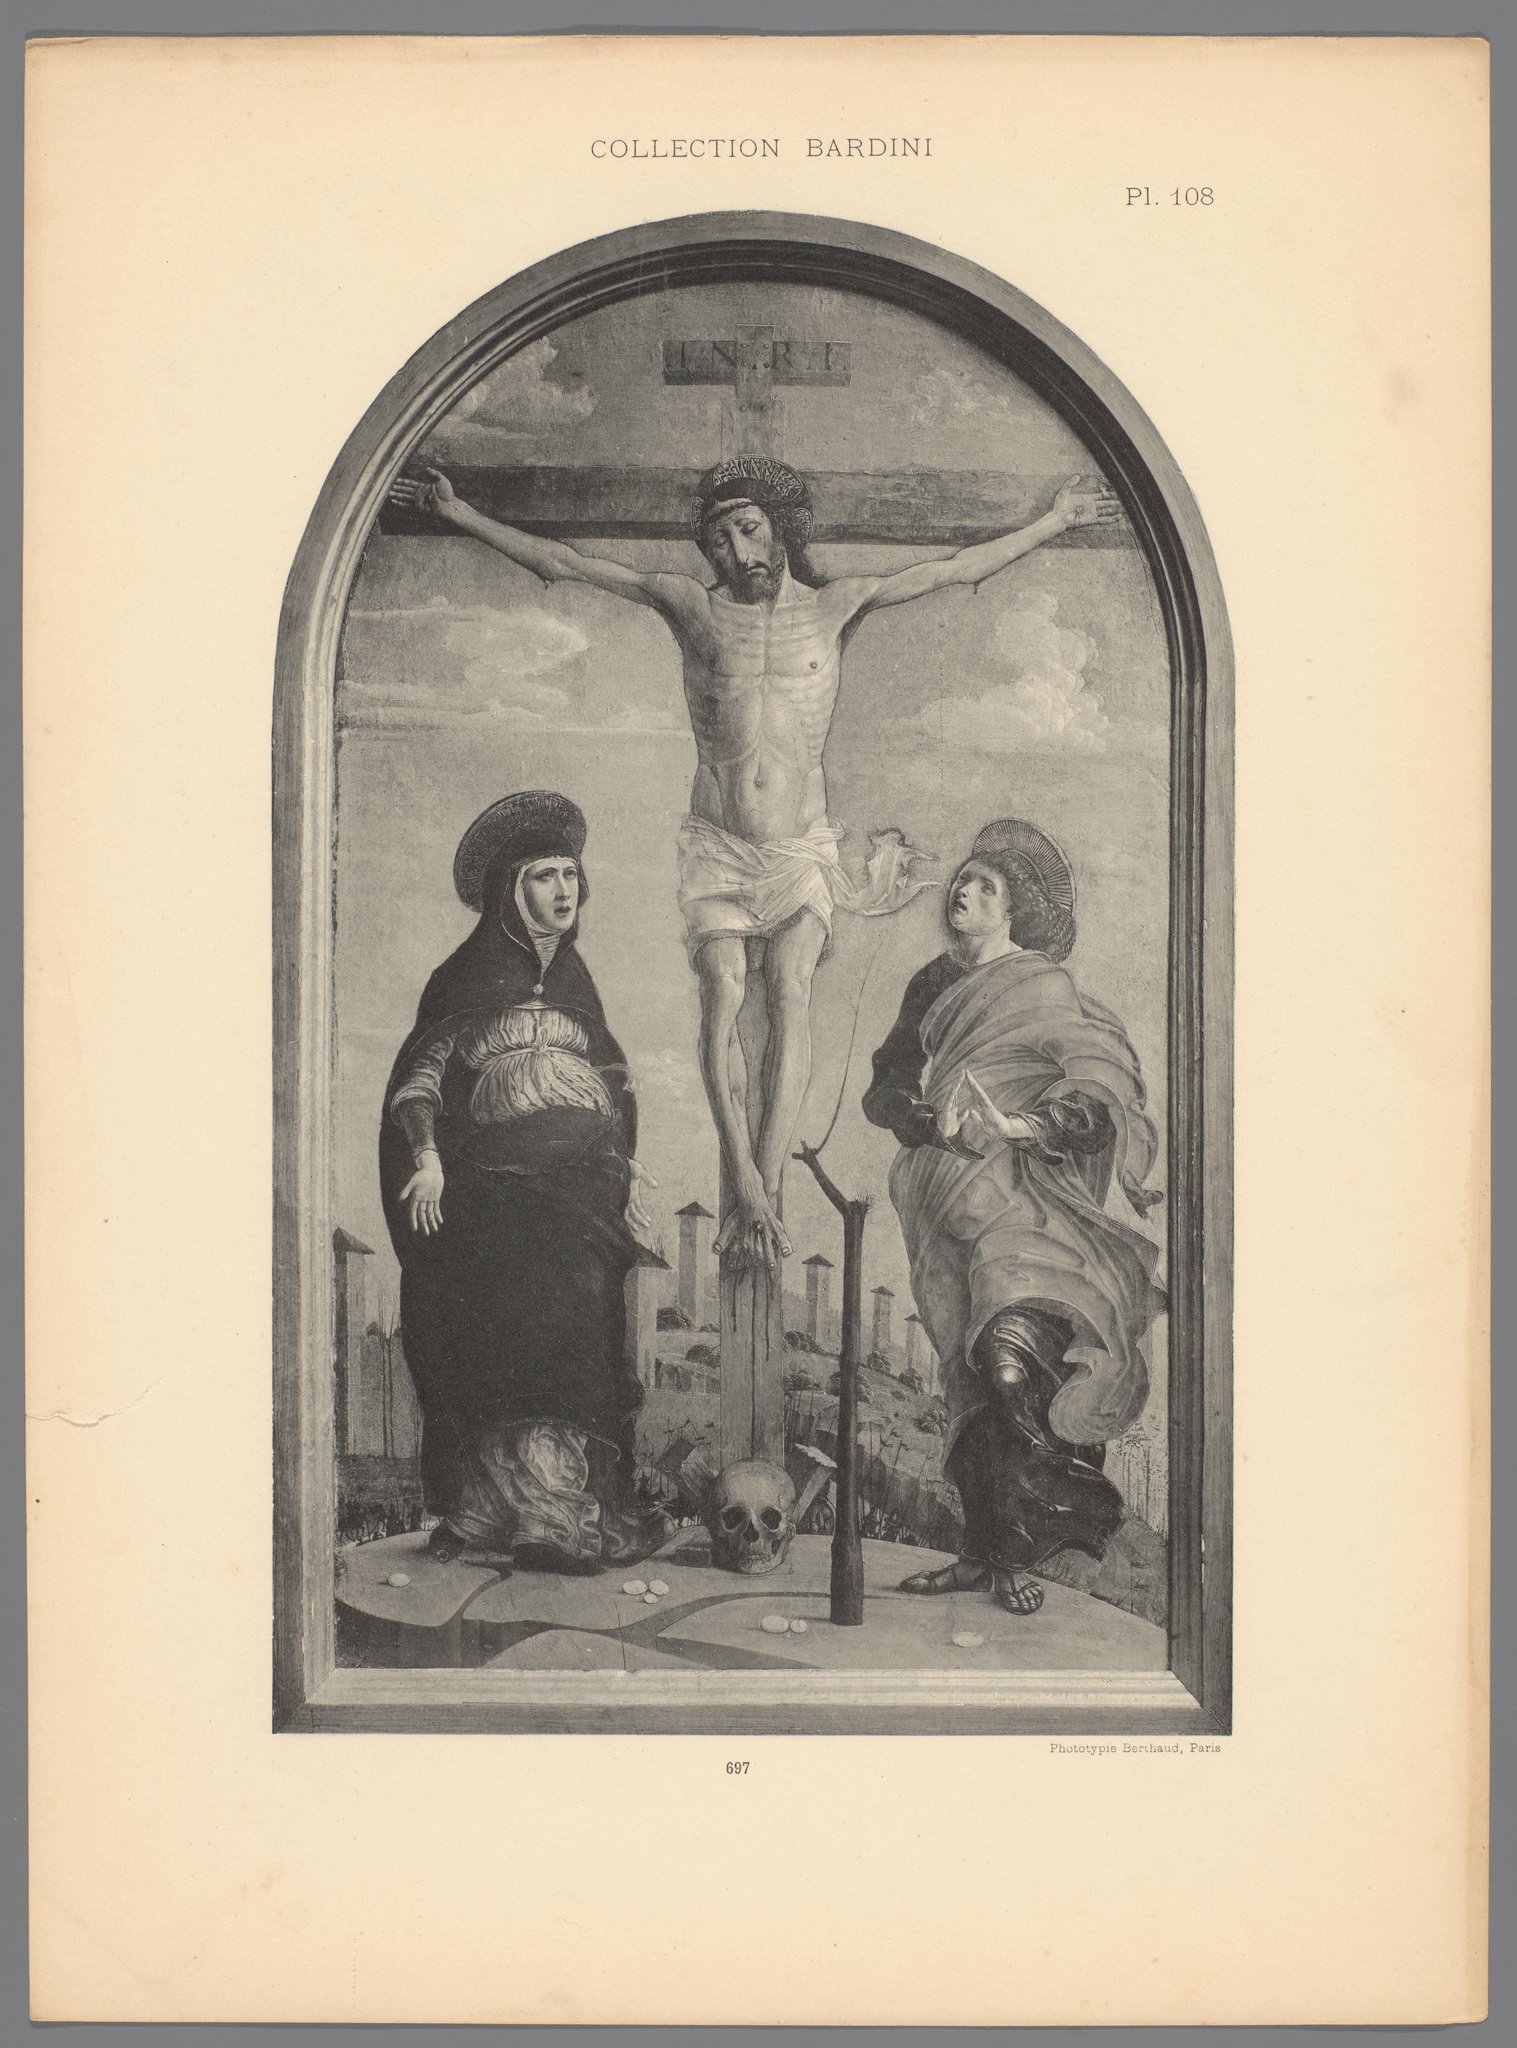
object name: reproduction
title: Reproductie van een schilderij van Christus aan het kruis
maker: Anonymous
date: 1875-1930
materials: paper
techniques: photograph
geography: florence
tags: picture, painting, crucified christ with mary and john on either side of the cross; holy rood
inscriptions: number: ‘Pl. 108’